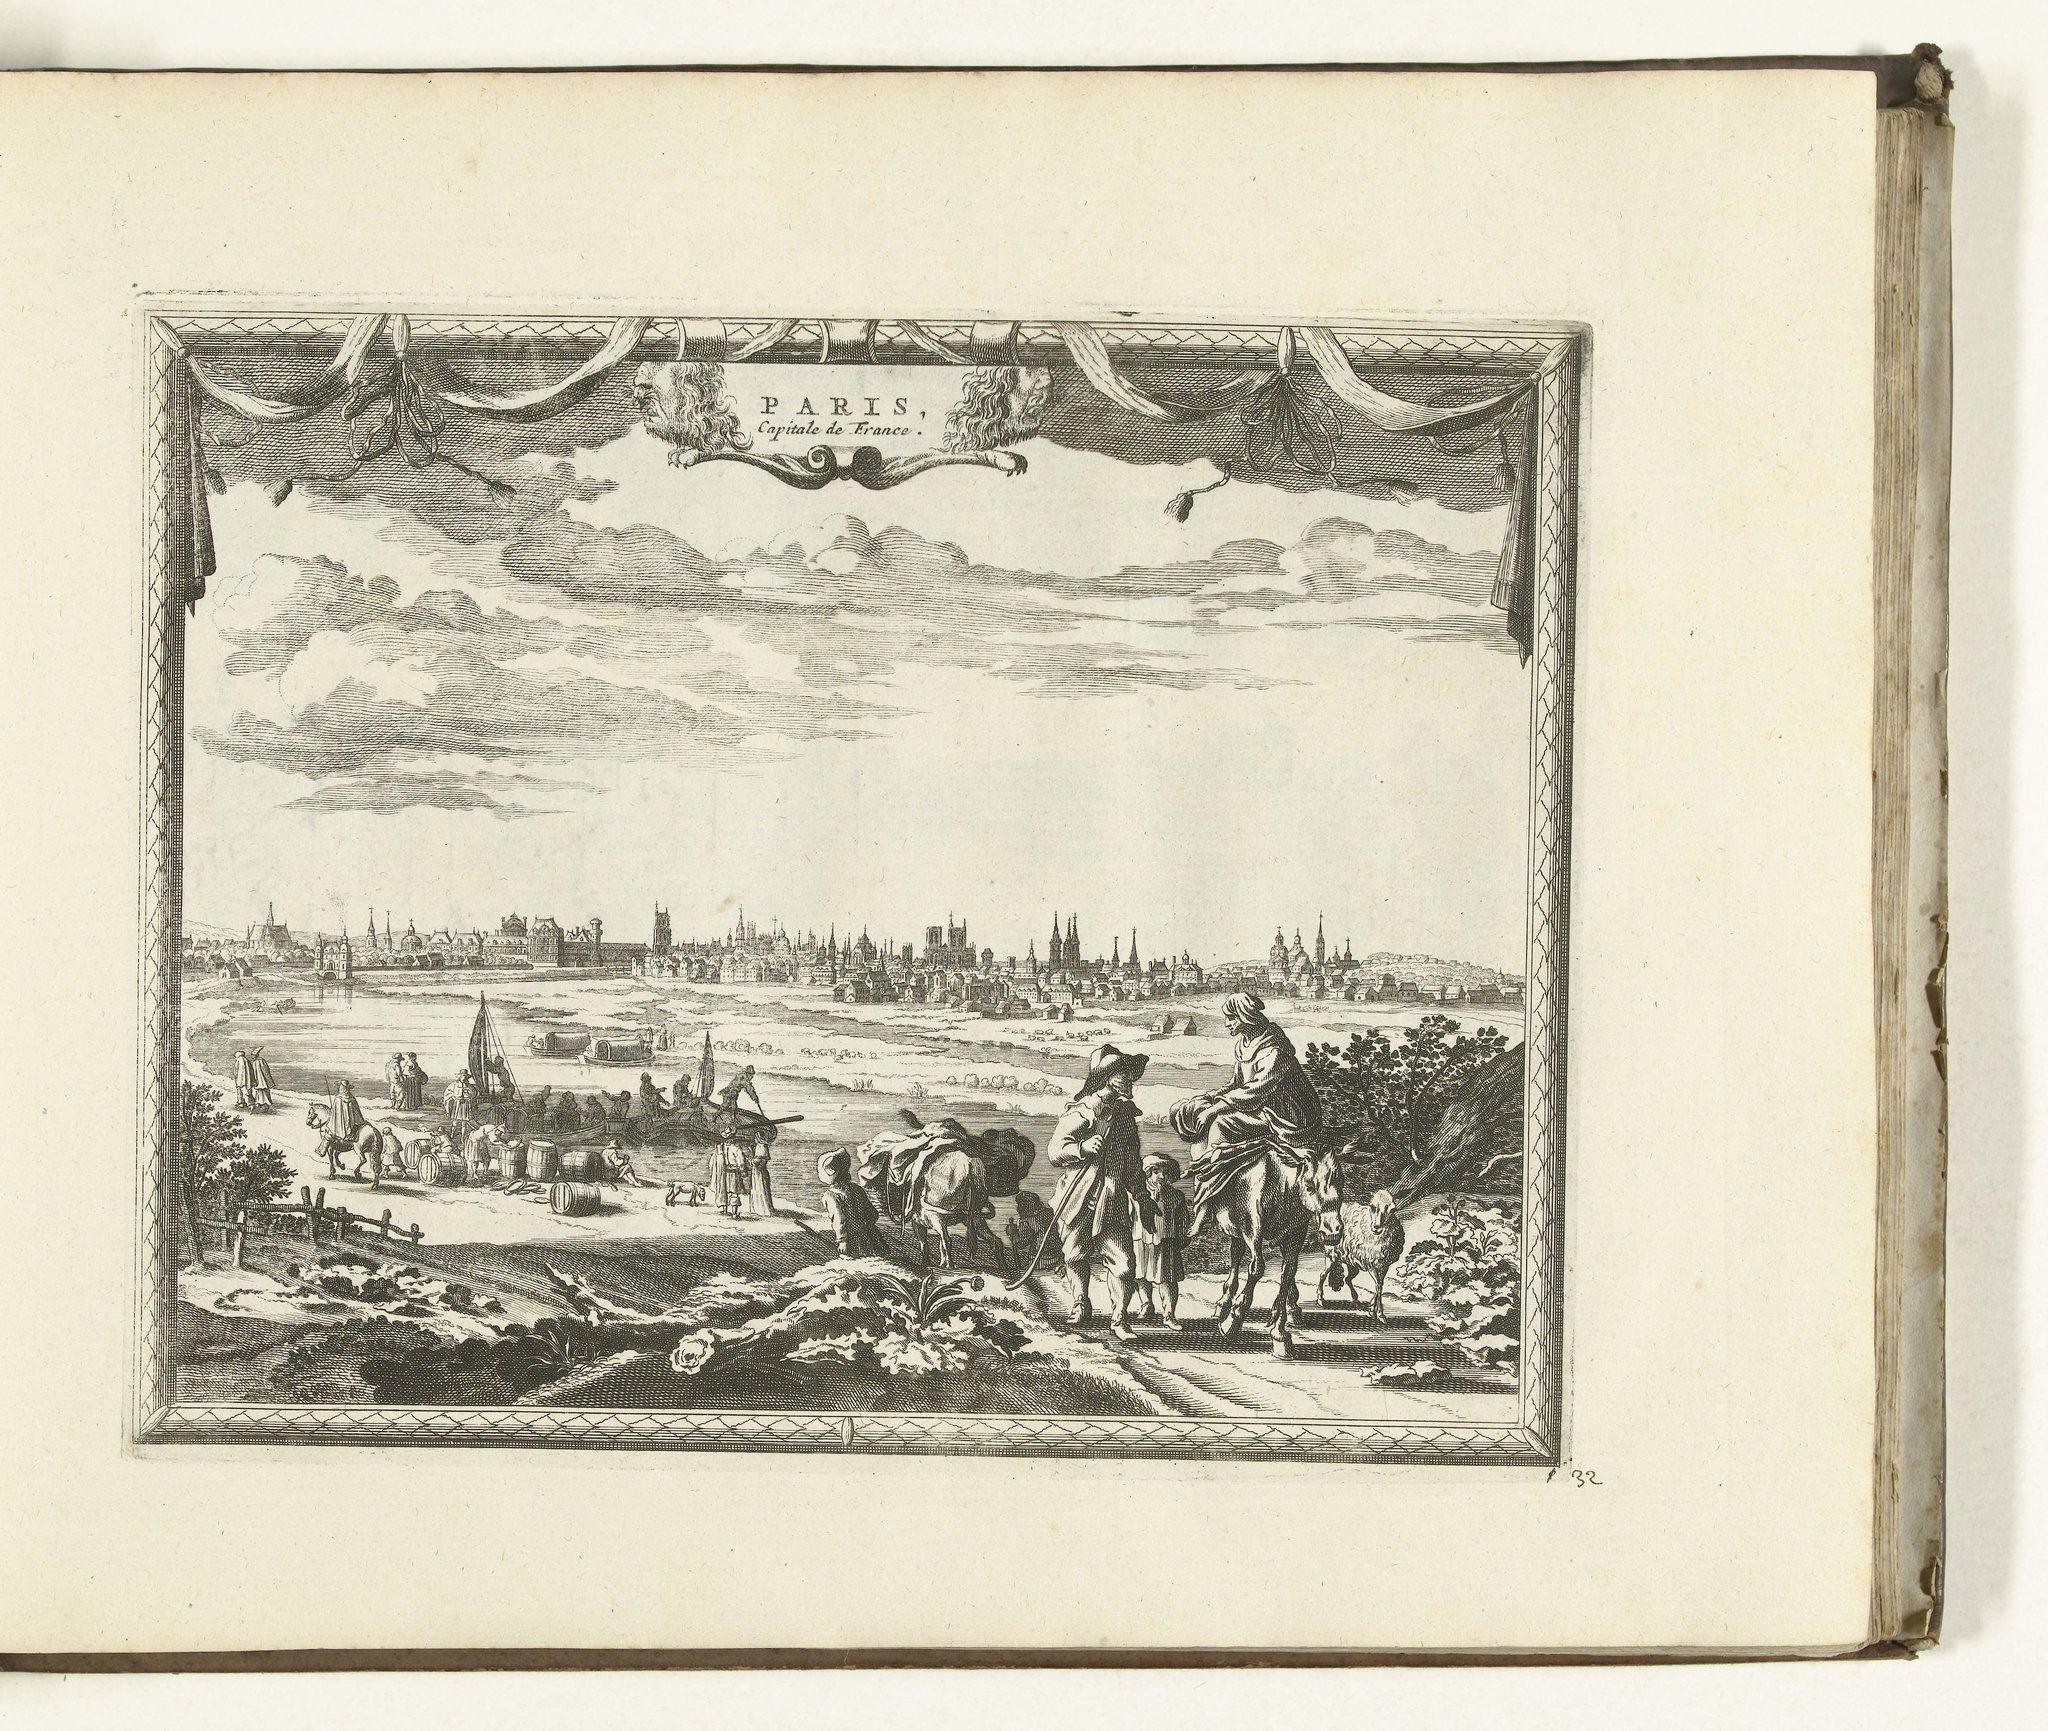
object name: print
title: Les Forces de l'Europe, Asie, Afrique et Amerique (...) Comme aussi les Cartes des Côtes de France et d'Espagne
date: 1726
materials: paper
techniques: engraving, etching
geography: northern netherlands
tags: paris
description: Gezicht op Parijs, op de voorgrond reizigers. Plaat nr. 32 in deel II van het prentwerk: Les Forces de l'Europe, Asie, Afrique et Amerique ... Comme aussi les Cartes des Côtes de France et d'Espagne uit 1726, dit eerste deel met 238 met de hand genummerde platen van vermaarde sterke steden en vestingen in het kader van de Spaanse Successieoorlog 1701-1713. Voor het merendeel zijn deze platen gekopieerd naar de anonieme Franse platen van vermaarde sterke steden en vestingen: in Les forces de l'Europe en in: Le theatre de la guerre, dans les Pays-Bas, beide oorspronkelijk uitgegeven door Nicolas de Fer te Parijs (1693-1697) in het kader van de Negenjarige Oorlog. Titel in het Frans.